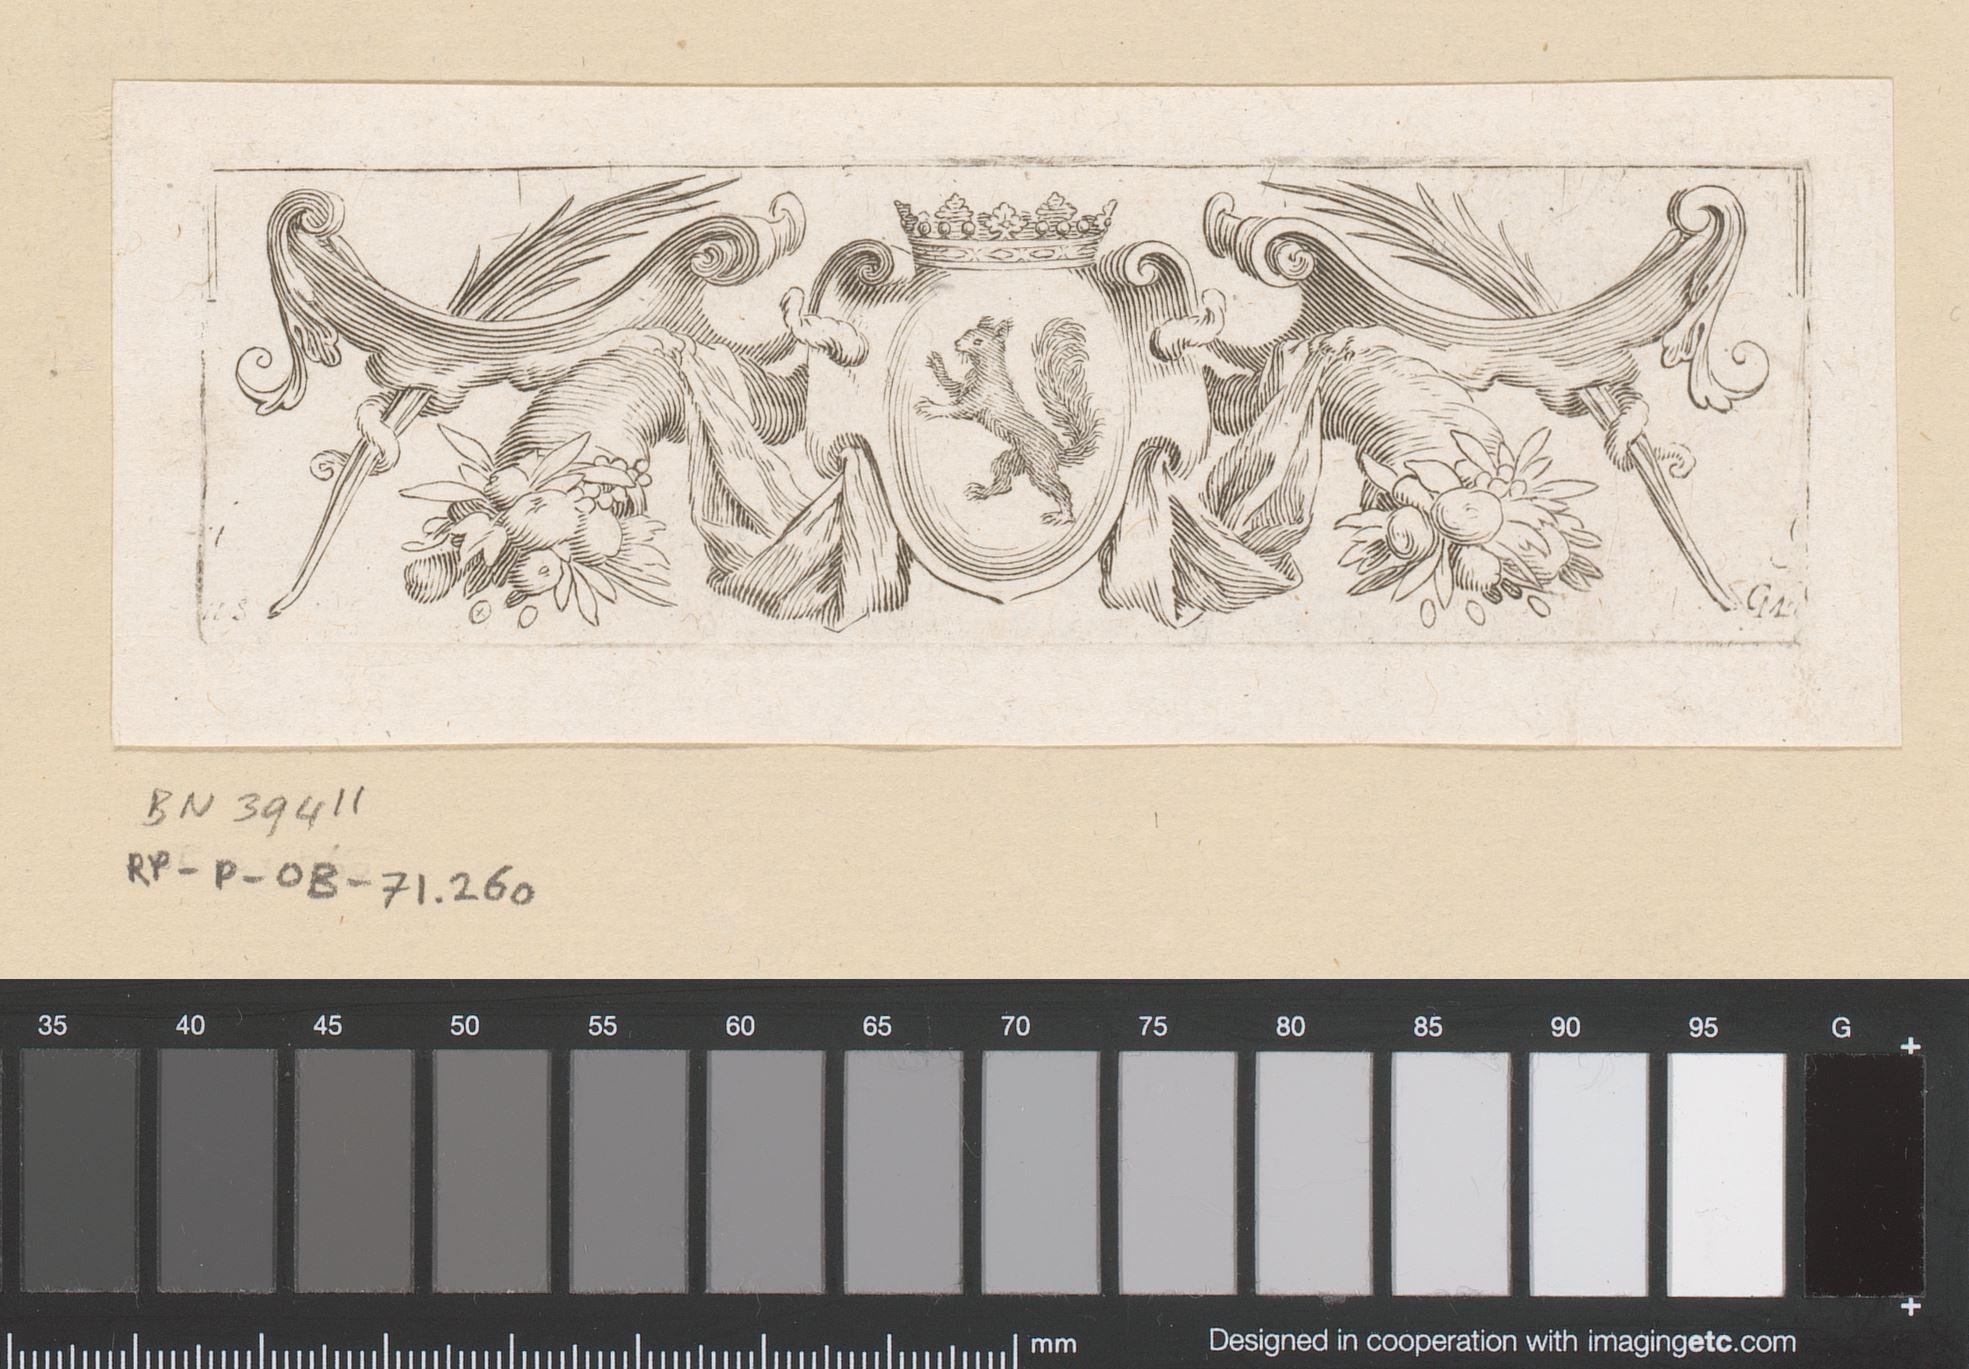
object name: print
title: Vignet met het wapen van Nicolas Fouquet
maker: claude mellan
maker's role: draughtsman, print maker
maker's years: 1598-1688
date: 1639-1643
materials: paper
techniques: engraving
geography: france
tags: paris, france, politician, nicolas fouquet, decoration of printed matter, rodents: squirrel, armorial bearing, heraldry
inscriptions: collector's mark: Lugt 240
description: Tussen 1639-1643 werkte Mellan samen met de Imprimerie Royale (IFF 17e siècle, p. 21-22). Hij vervaardigde verschillende vignetten, letters, culs-de-lampe en decoratieve banden (IFF 17e siècle, p. 215-220).